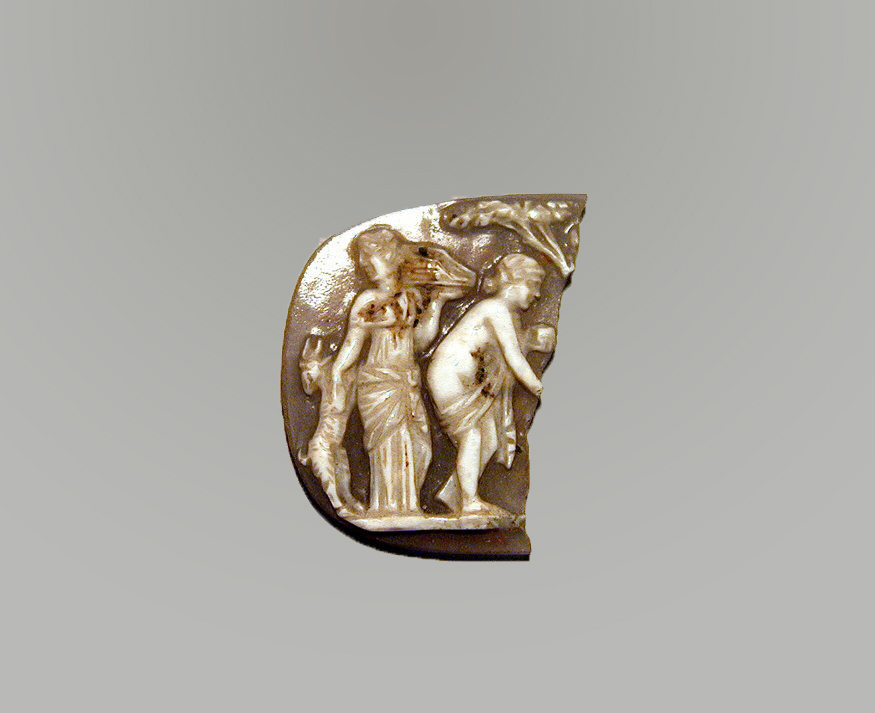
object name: cameo, fragmentary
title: Sardonyx cameo fragment with a sacrificial scene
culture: greek or roman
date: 100 BCE-100 CE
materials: gemstone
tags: animals,men,women